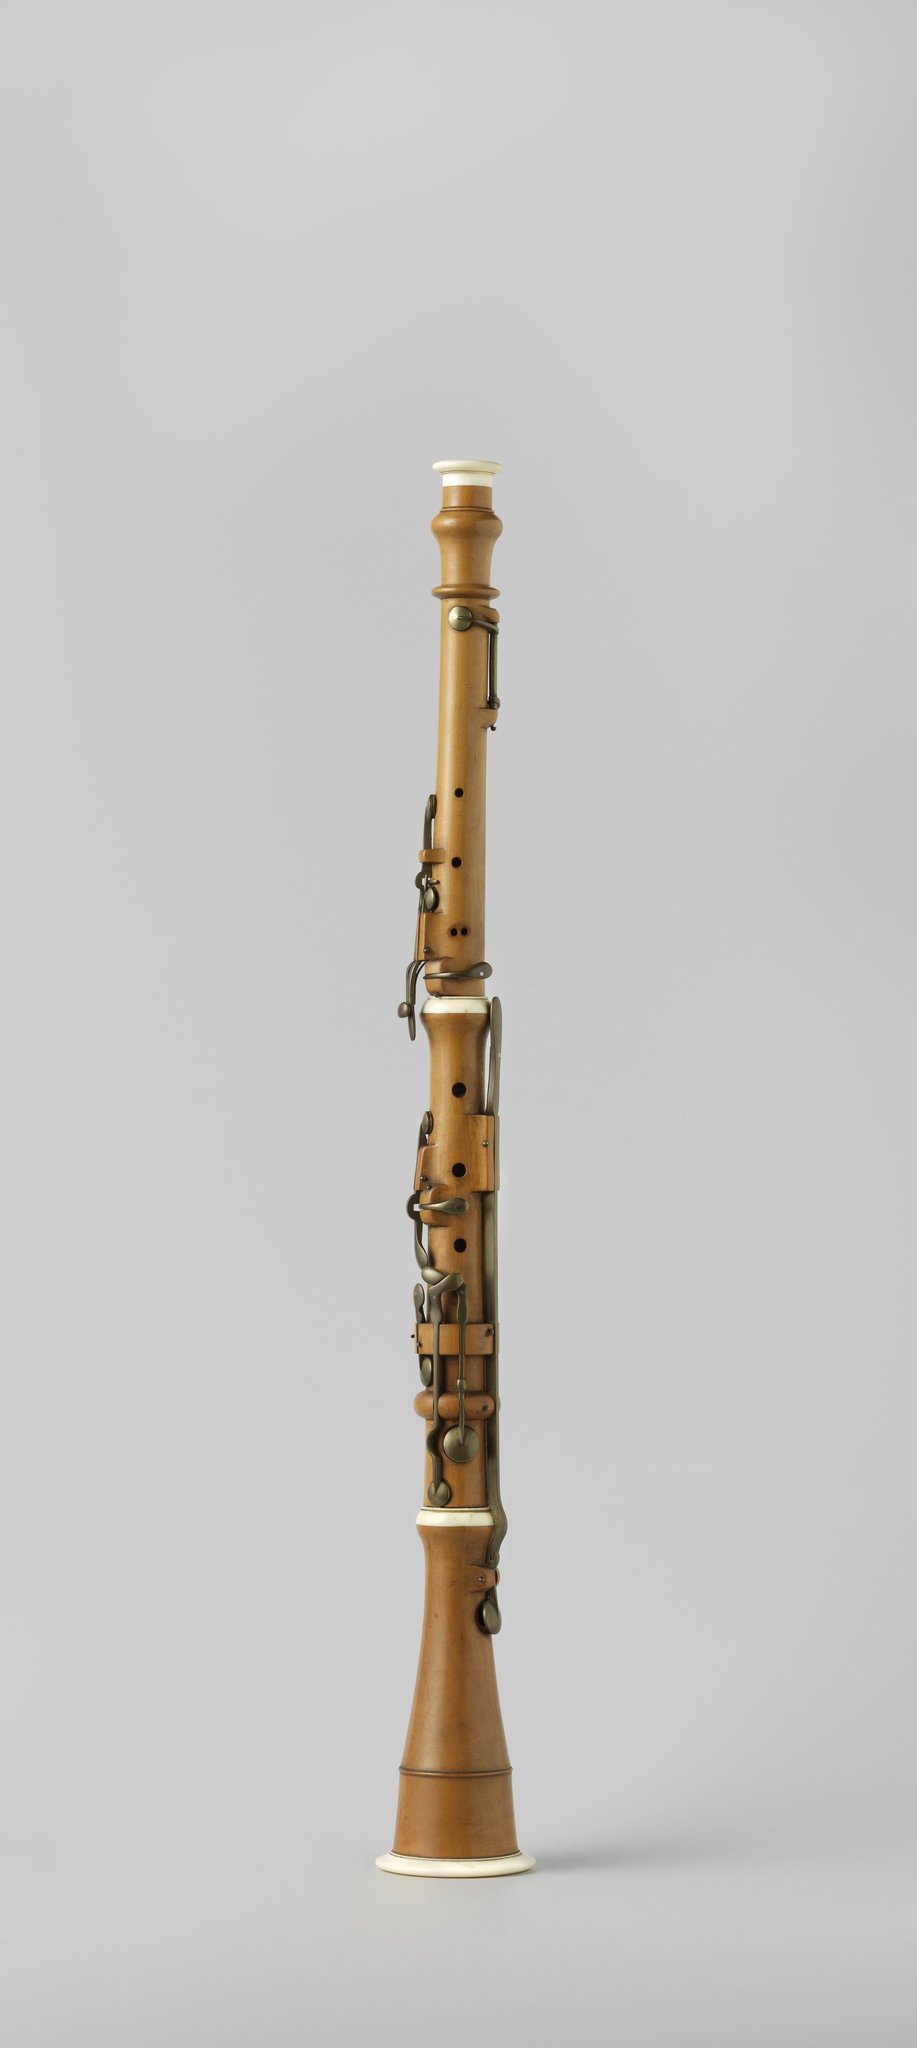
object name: wind instrument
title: Oboe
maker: Anonymous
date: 1830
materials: wood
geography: germany